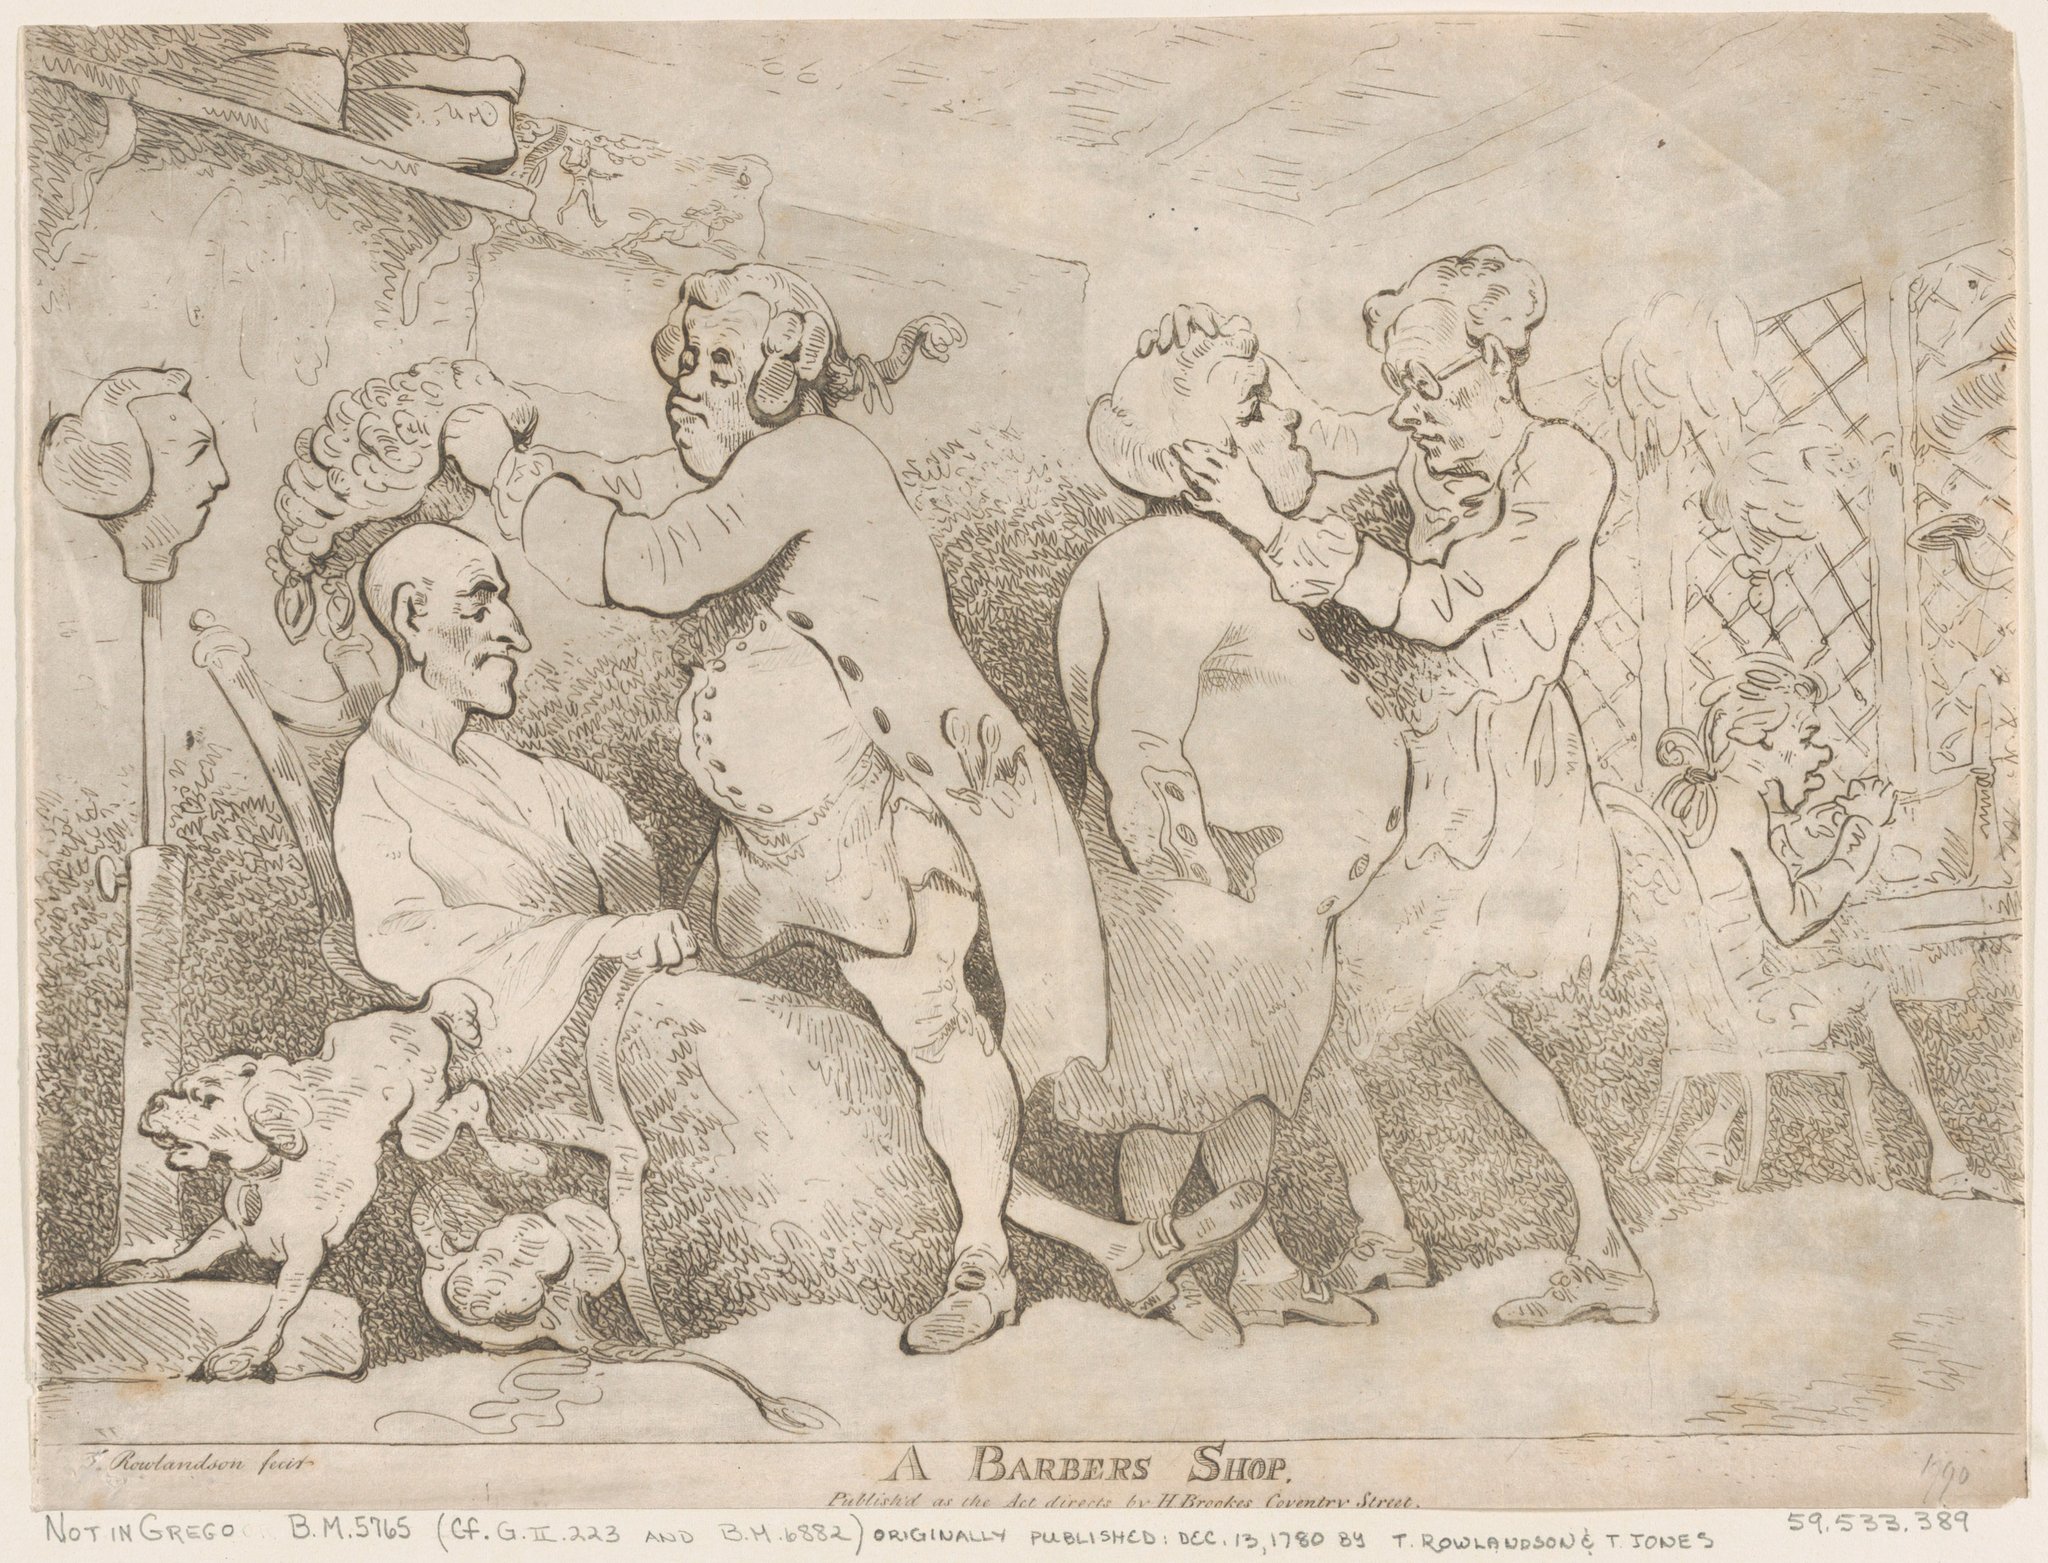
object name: print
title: A Barber's Shop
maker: thomas rowlandson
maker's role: artist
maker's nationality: british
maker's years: 1757-1827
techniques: aquatint, etching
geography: london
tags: satire,men,dogs